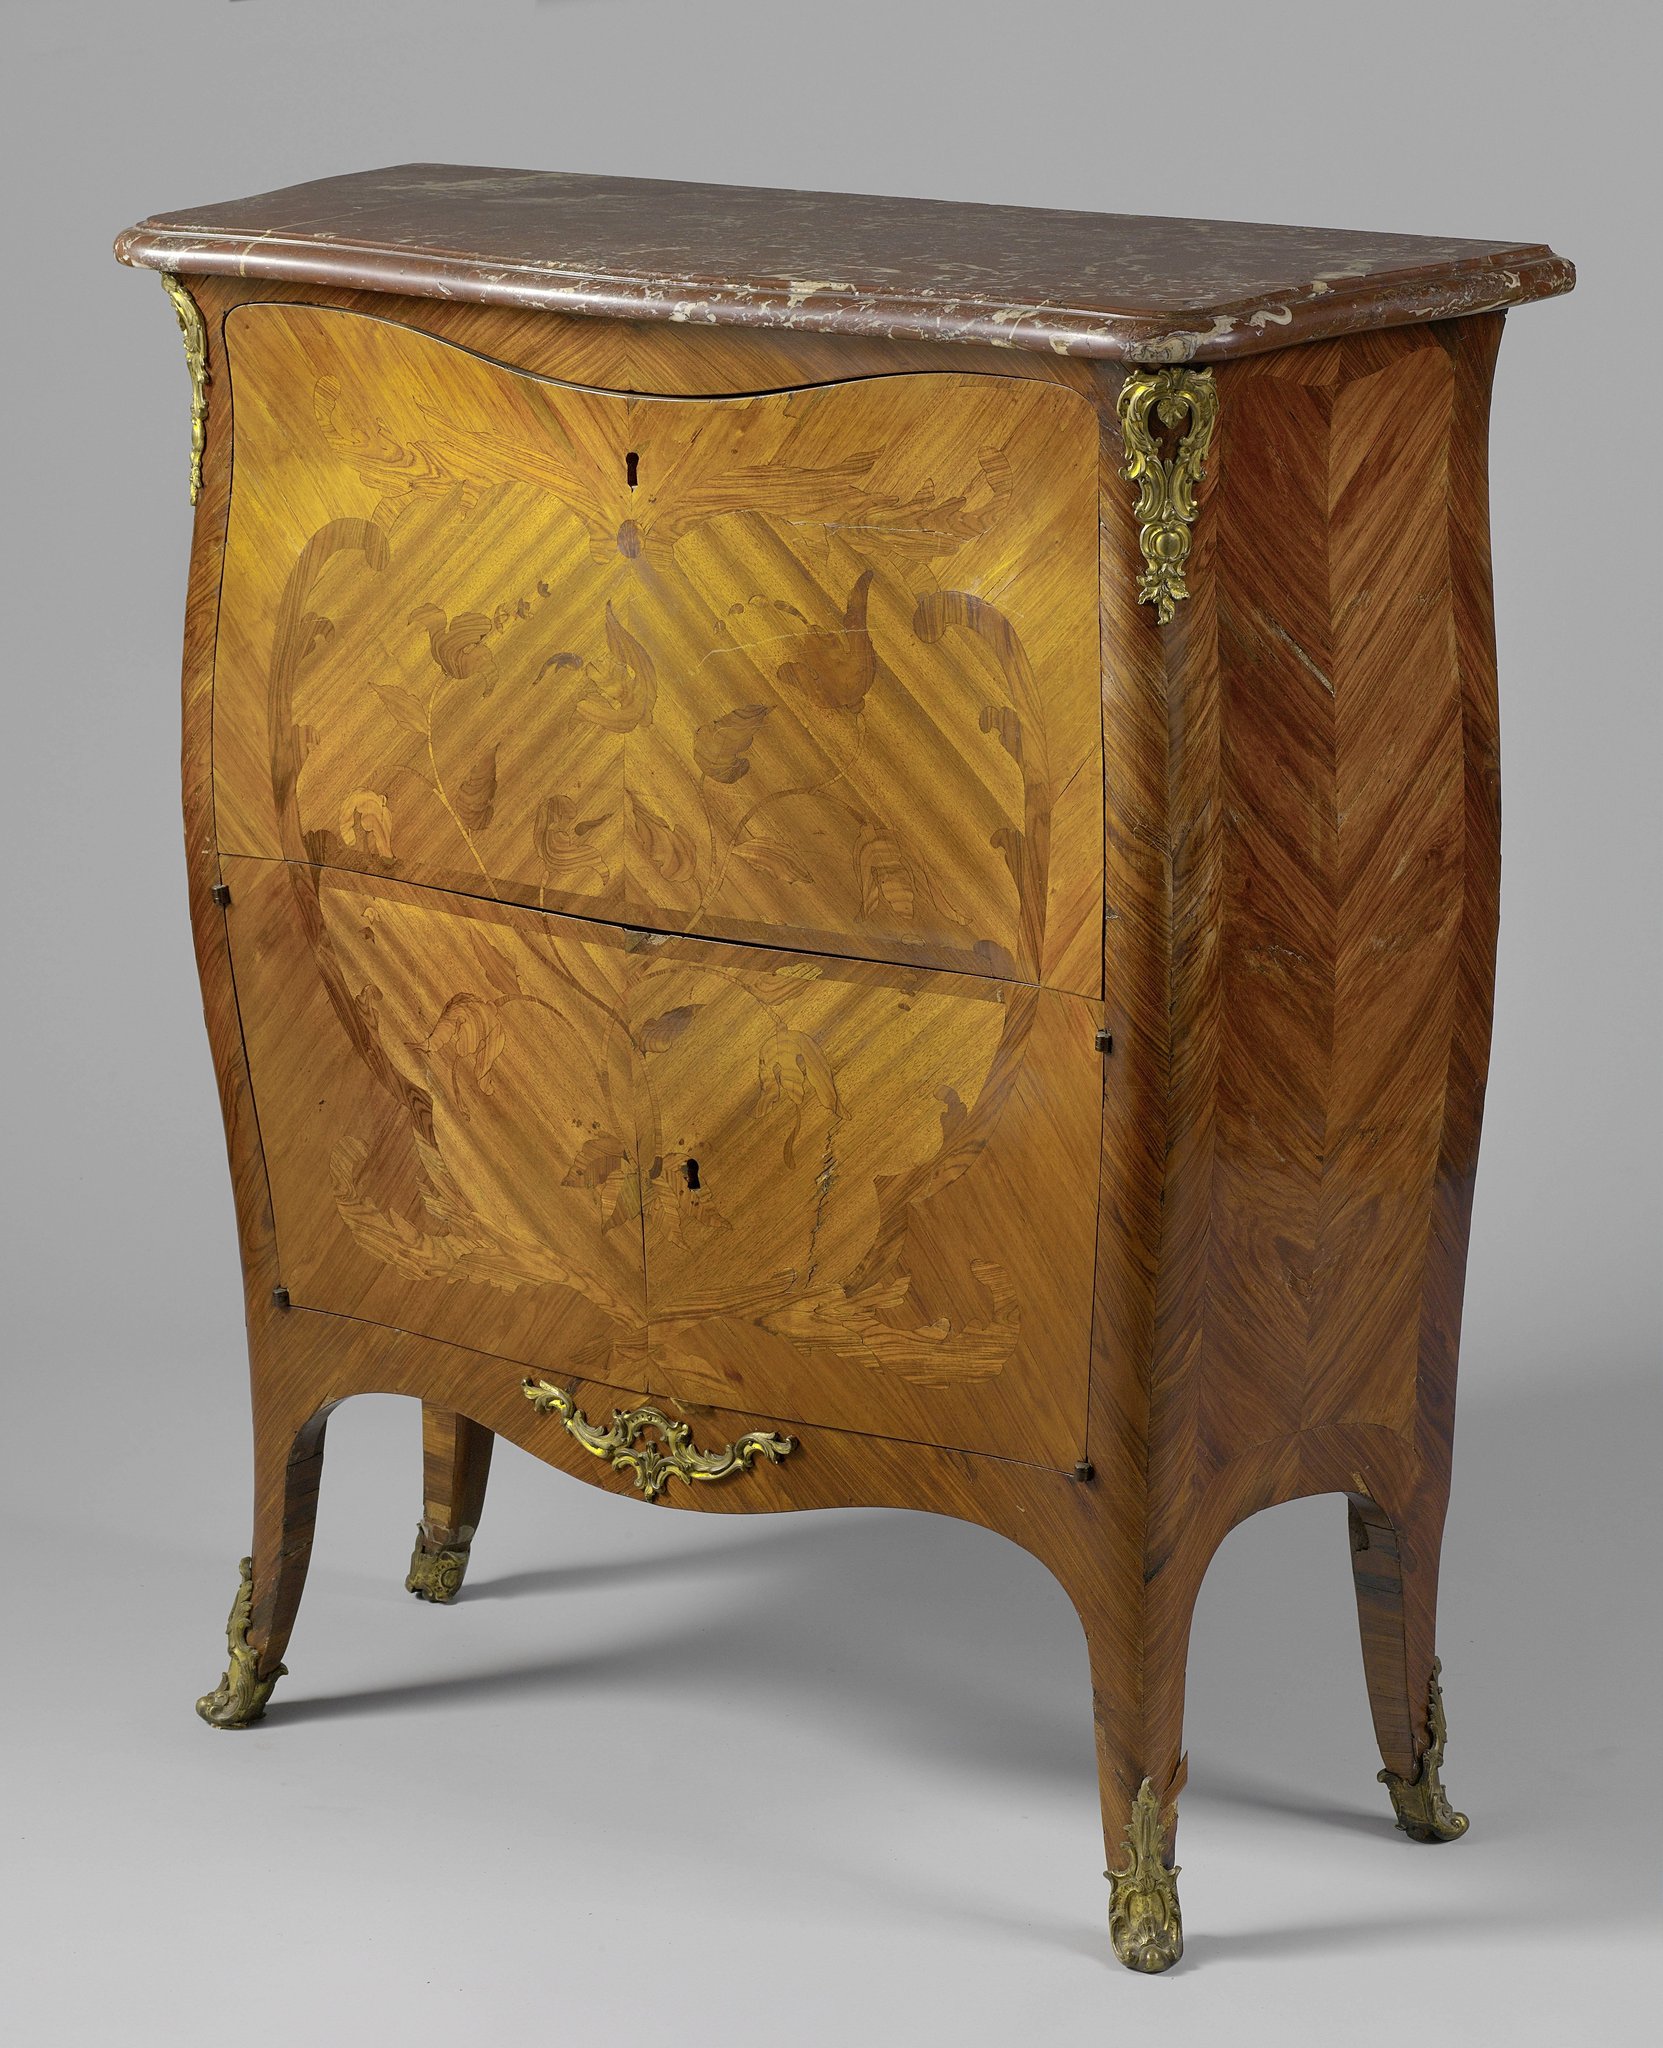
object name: secretary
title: Secretaire, versierd in marqueterie met onder andere een tulpenboeket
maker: Anonymous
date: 1750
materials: bronze, leather, marble, wood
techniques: gilding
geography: france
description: Secretaire versierd met marqueterie van roze-, palissanderhout en andere houtsoorten op eikenhouten kern. De overhoeks geplaatste poten, de voorste met S-vormige hoekstijlen, gaan over in de geschulpte voorregel en zijregels. Het gebuikte front vertoont een door bladvoluten gevormd hartvormig schild waarin een tulpenboeket. De bovenhelft dient als schrijfblad voor een, in tweeën gedeelde, bovenkast; de onderhelft heeft twee deuren. Rocaille-beslag onderaan de poten, bovenaan de stijlen en op voorregel.